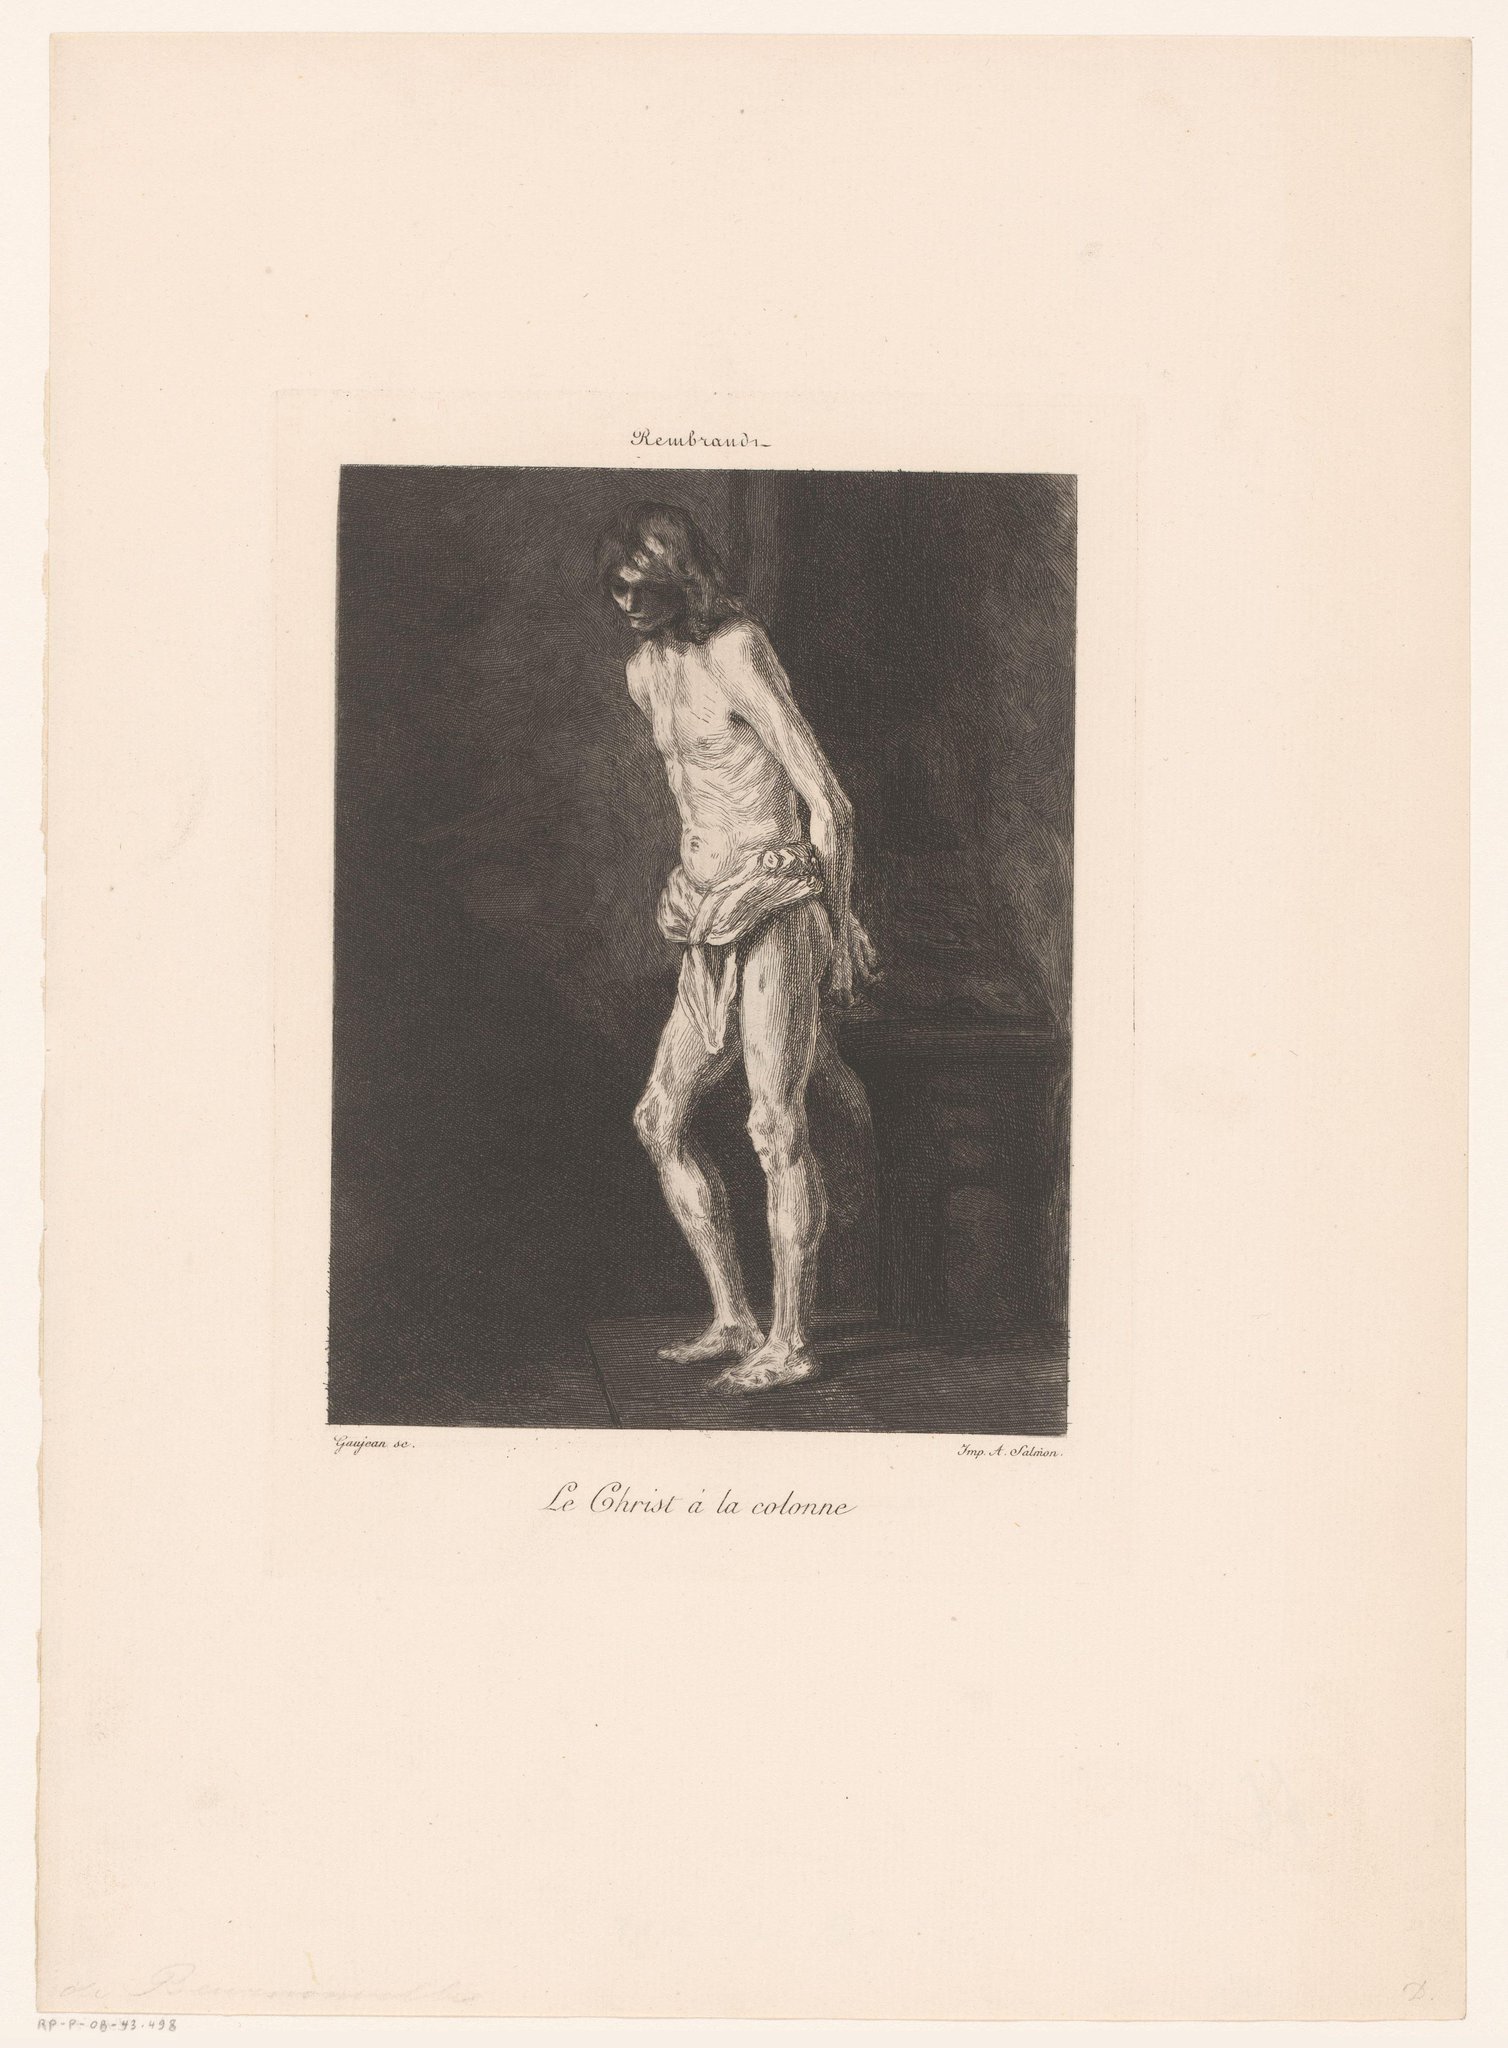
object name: print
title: Serie prenten naar schilderijen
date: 1860-1900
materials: paper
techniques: drypoint, etching, intaglio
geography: france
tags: column (of the flagellation) ~ instruments of the passion, tortures of christ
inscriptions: collector's mark: Lugt 2228